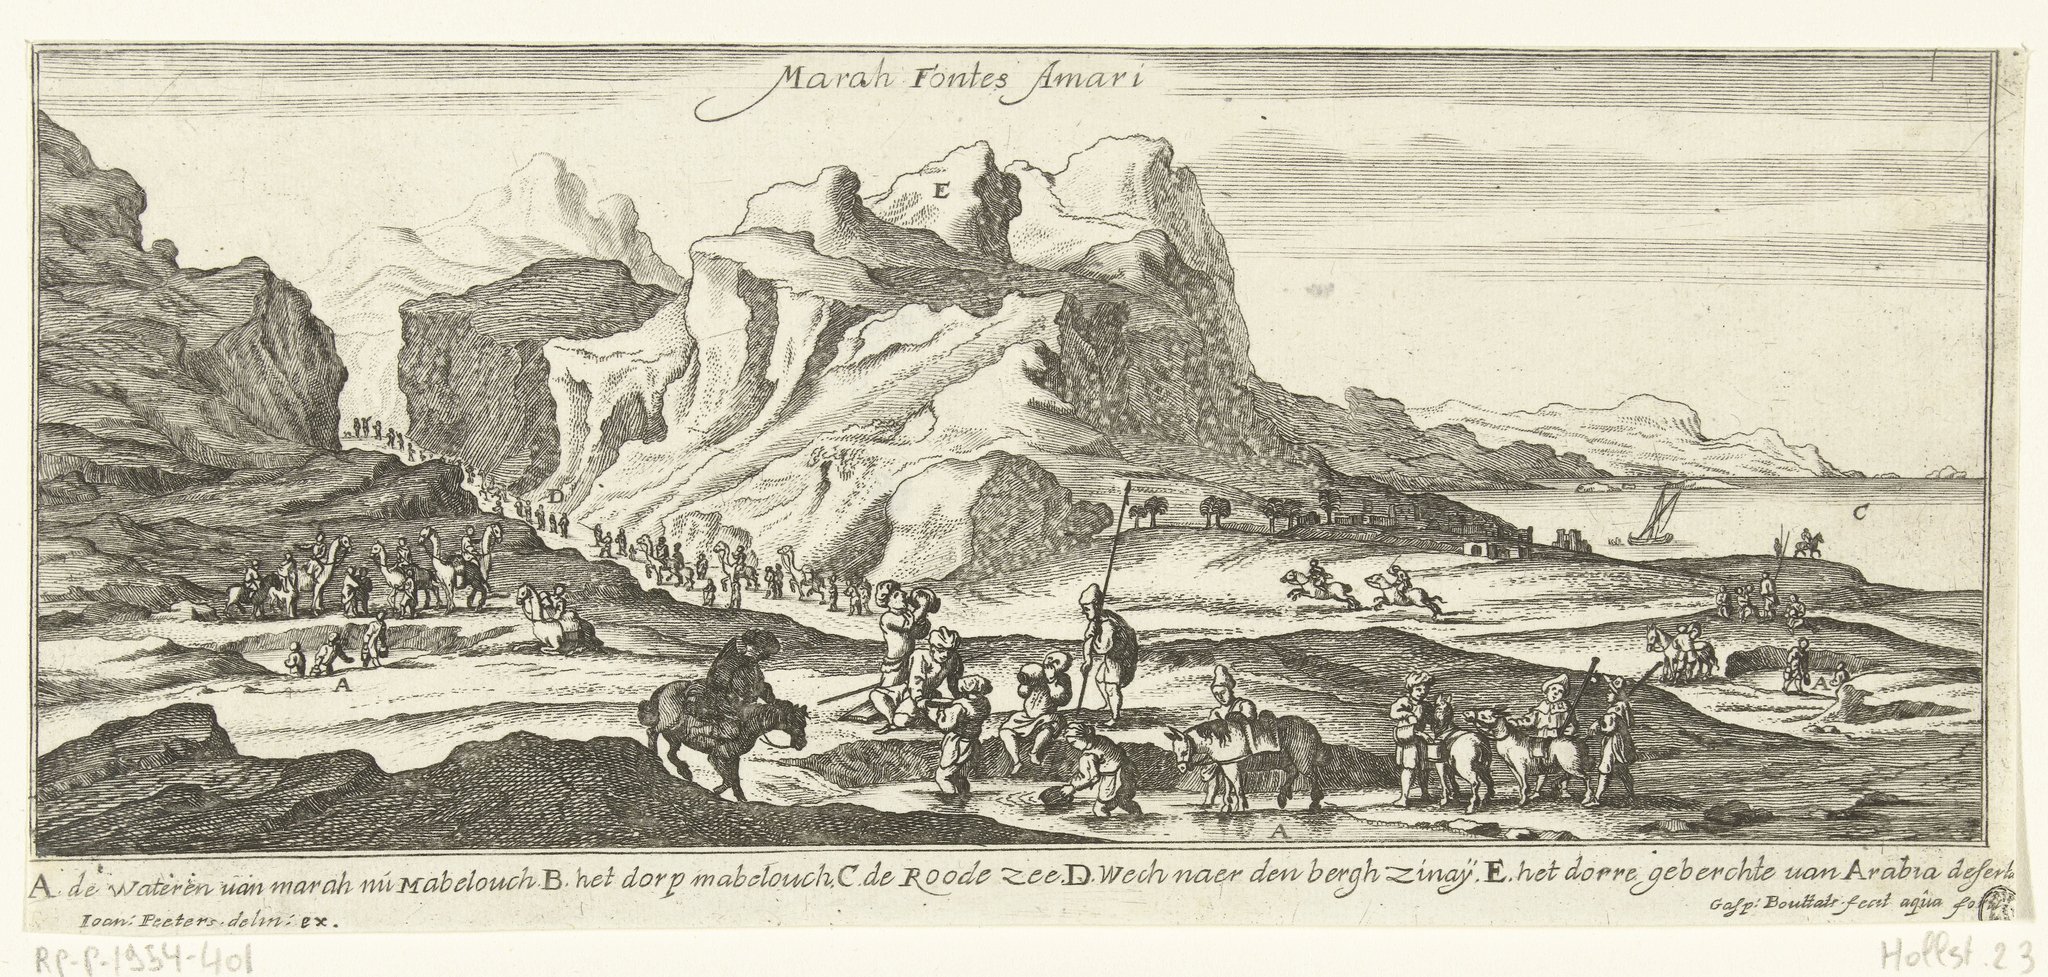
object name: print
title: Gezicht op de waterbron van Mara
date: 1672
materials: paper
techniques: etching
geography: antwerp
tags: miracle of the sweetening of the water of marah, prospect of city, town panorama, silhouette of city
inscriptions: collector's mark: Lugt 971, collector's mark: Lugt 2760, collector's mark: Lugt 2228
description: Gezicht op de waterbron van Mabelouch. In de tijden van Mozes heette de waterbron Mara. Tijdens de Uittocht uit Egypte had Mozes door een mirakel deze waterbron zoet in plaats van bitter gemaakt (Exodus 15:22). Op de achtergrond rechts de Rode Zee en links de weg naar de berg Sinaï. Op de voorgrond een waterput waar een karavaan zich bevoorraadt. De prent heeft een Nederlands onderschrift met verwijzingen naar gebouwen en plaatsen op de prent.